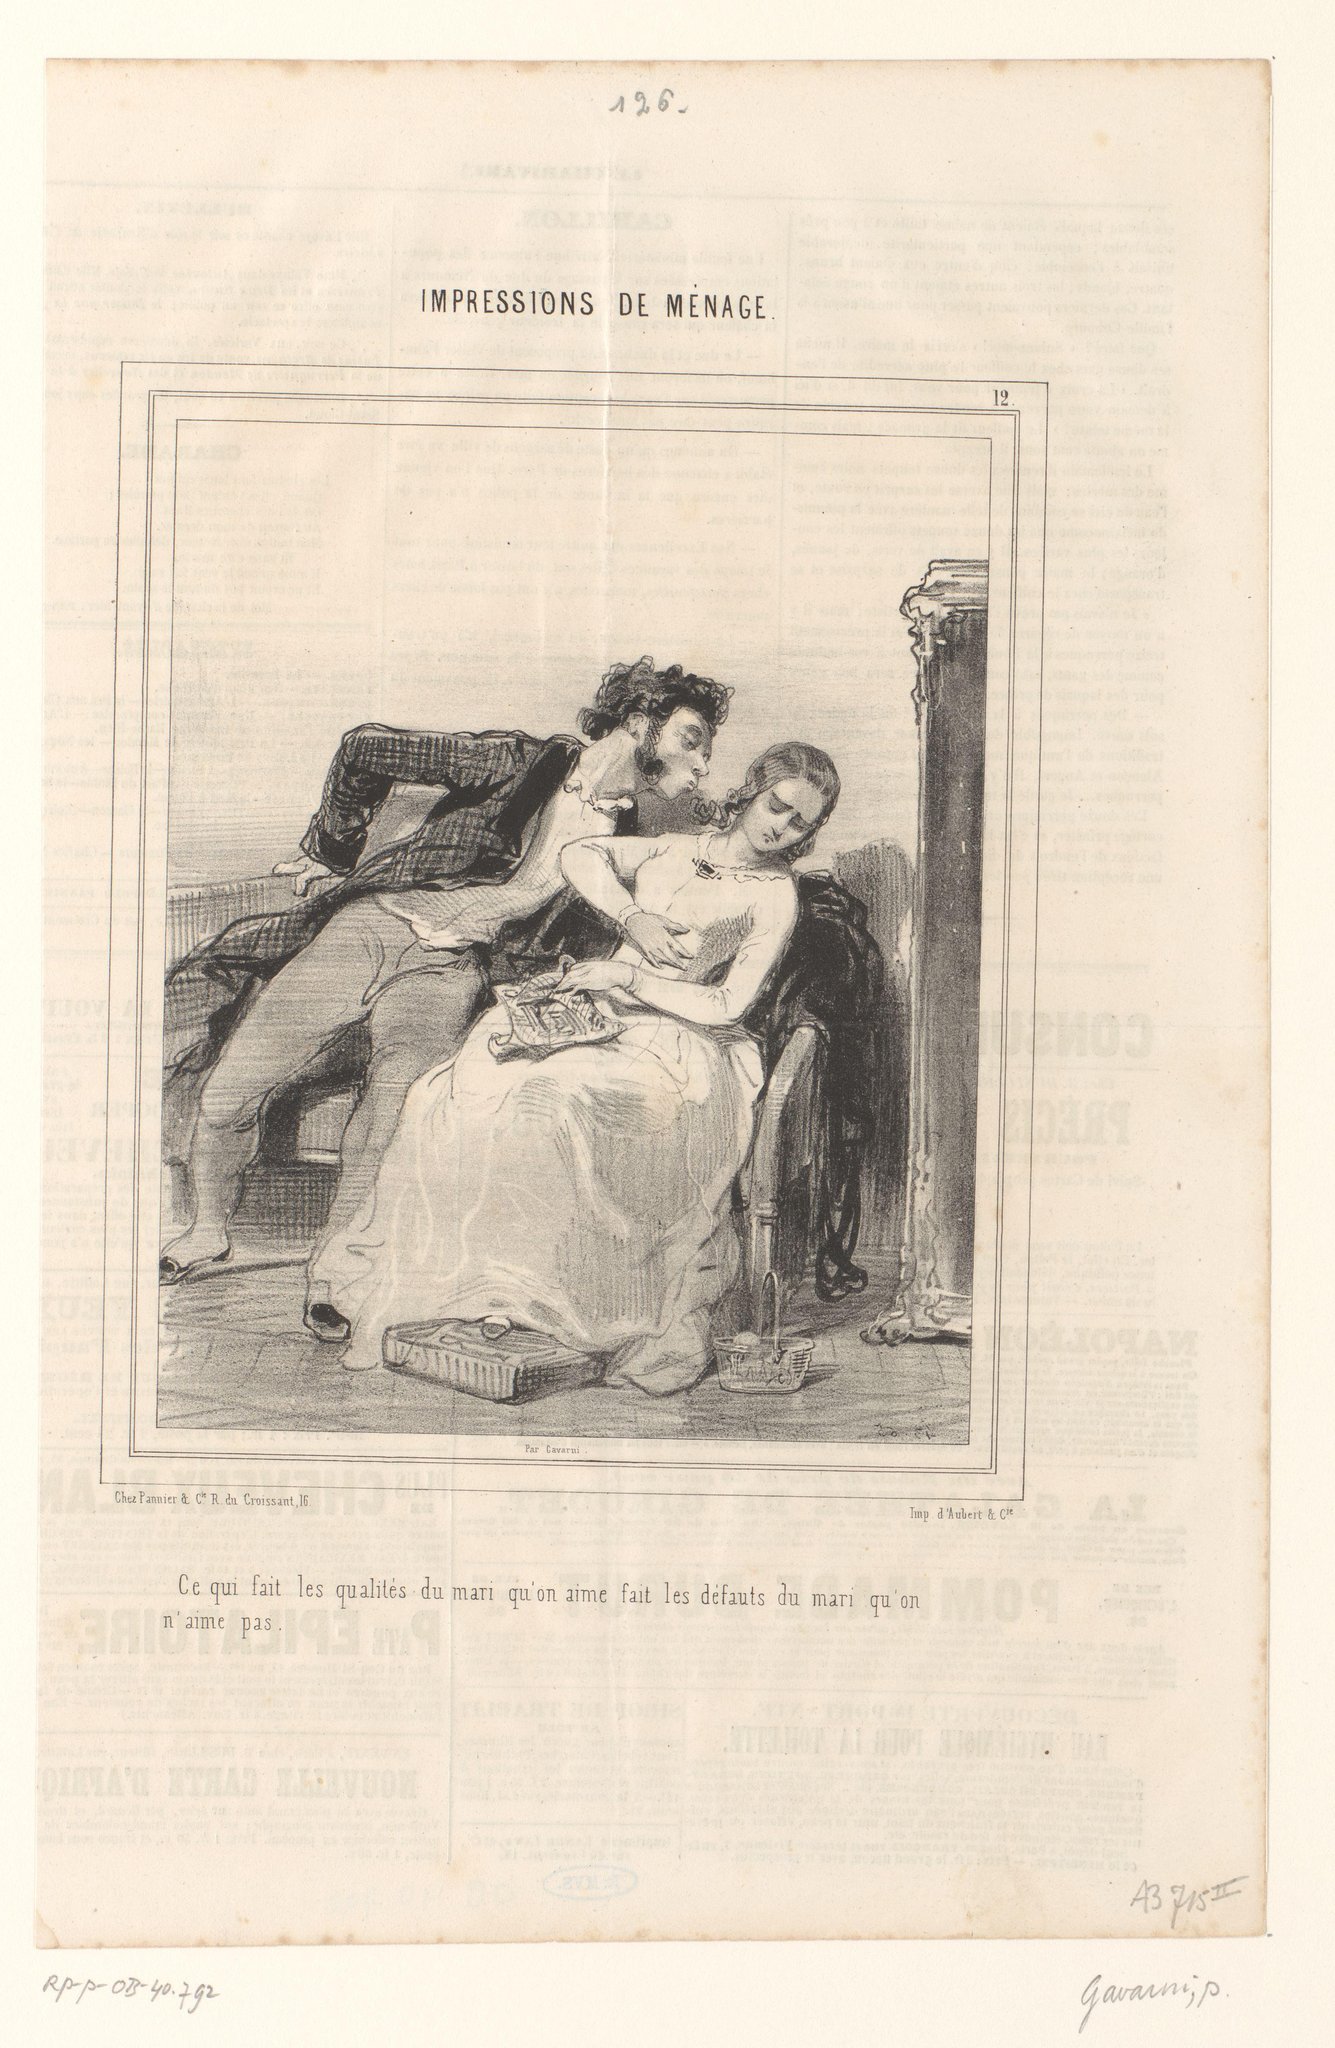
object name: print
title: Impressies van het huwelijk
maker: paul gavarni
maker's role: draughtsman, print maker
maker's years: 1804-1866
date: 1843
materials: paper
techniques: lithograph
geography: paris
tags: (lovers) kissing each other, woman in flight (one-sided courting), satire on marriage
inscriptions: collector's mark: Lugt 2228a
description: Prent gebruikt voor: Le Charivari, 6 september 1843.